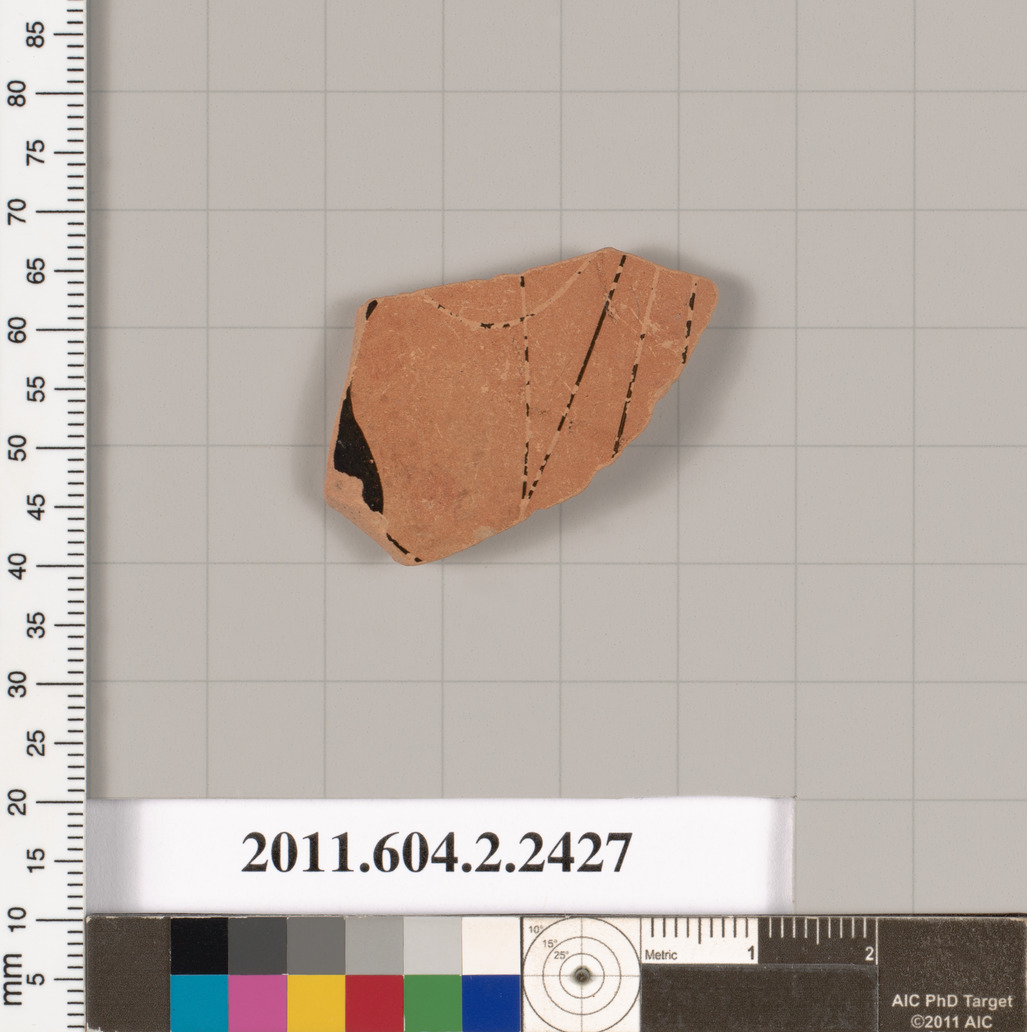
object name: undetermined closed shape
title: Terracotta fragment of a closed shape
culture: greek, attic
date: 490-470 BCE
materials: terracotta